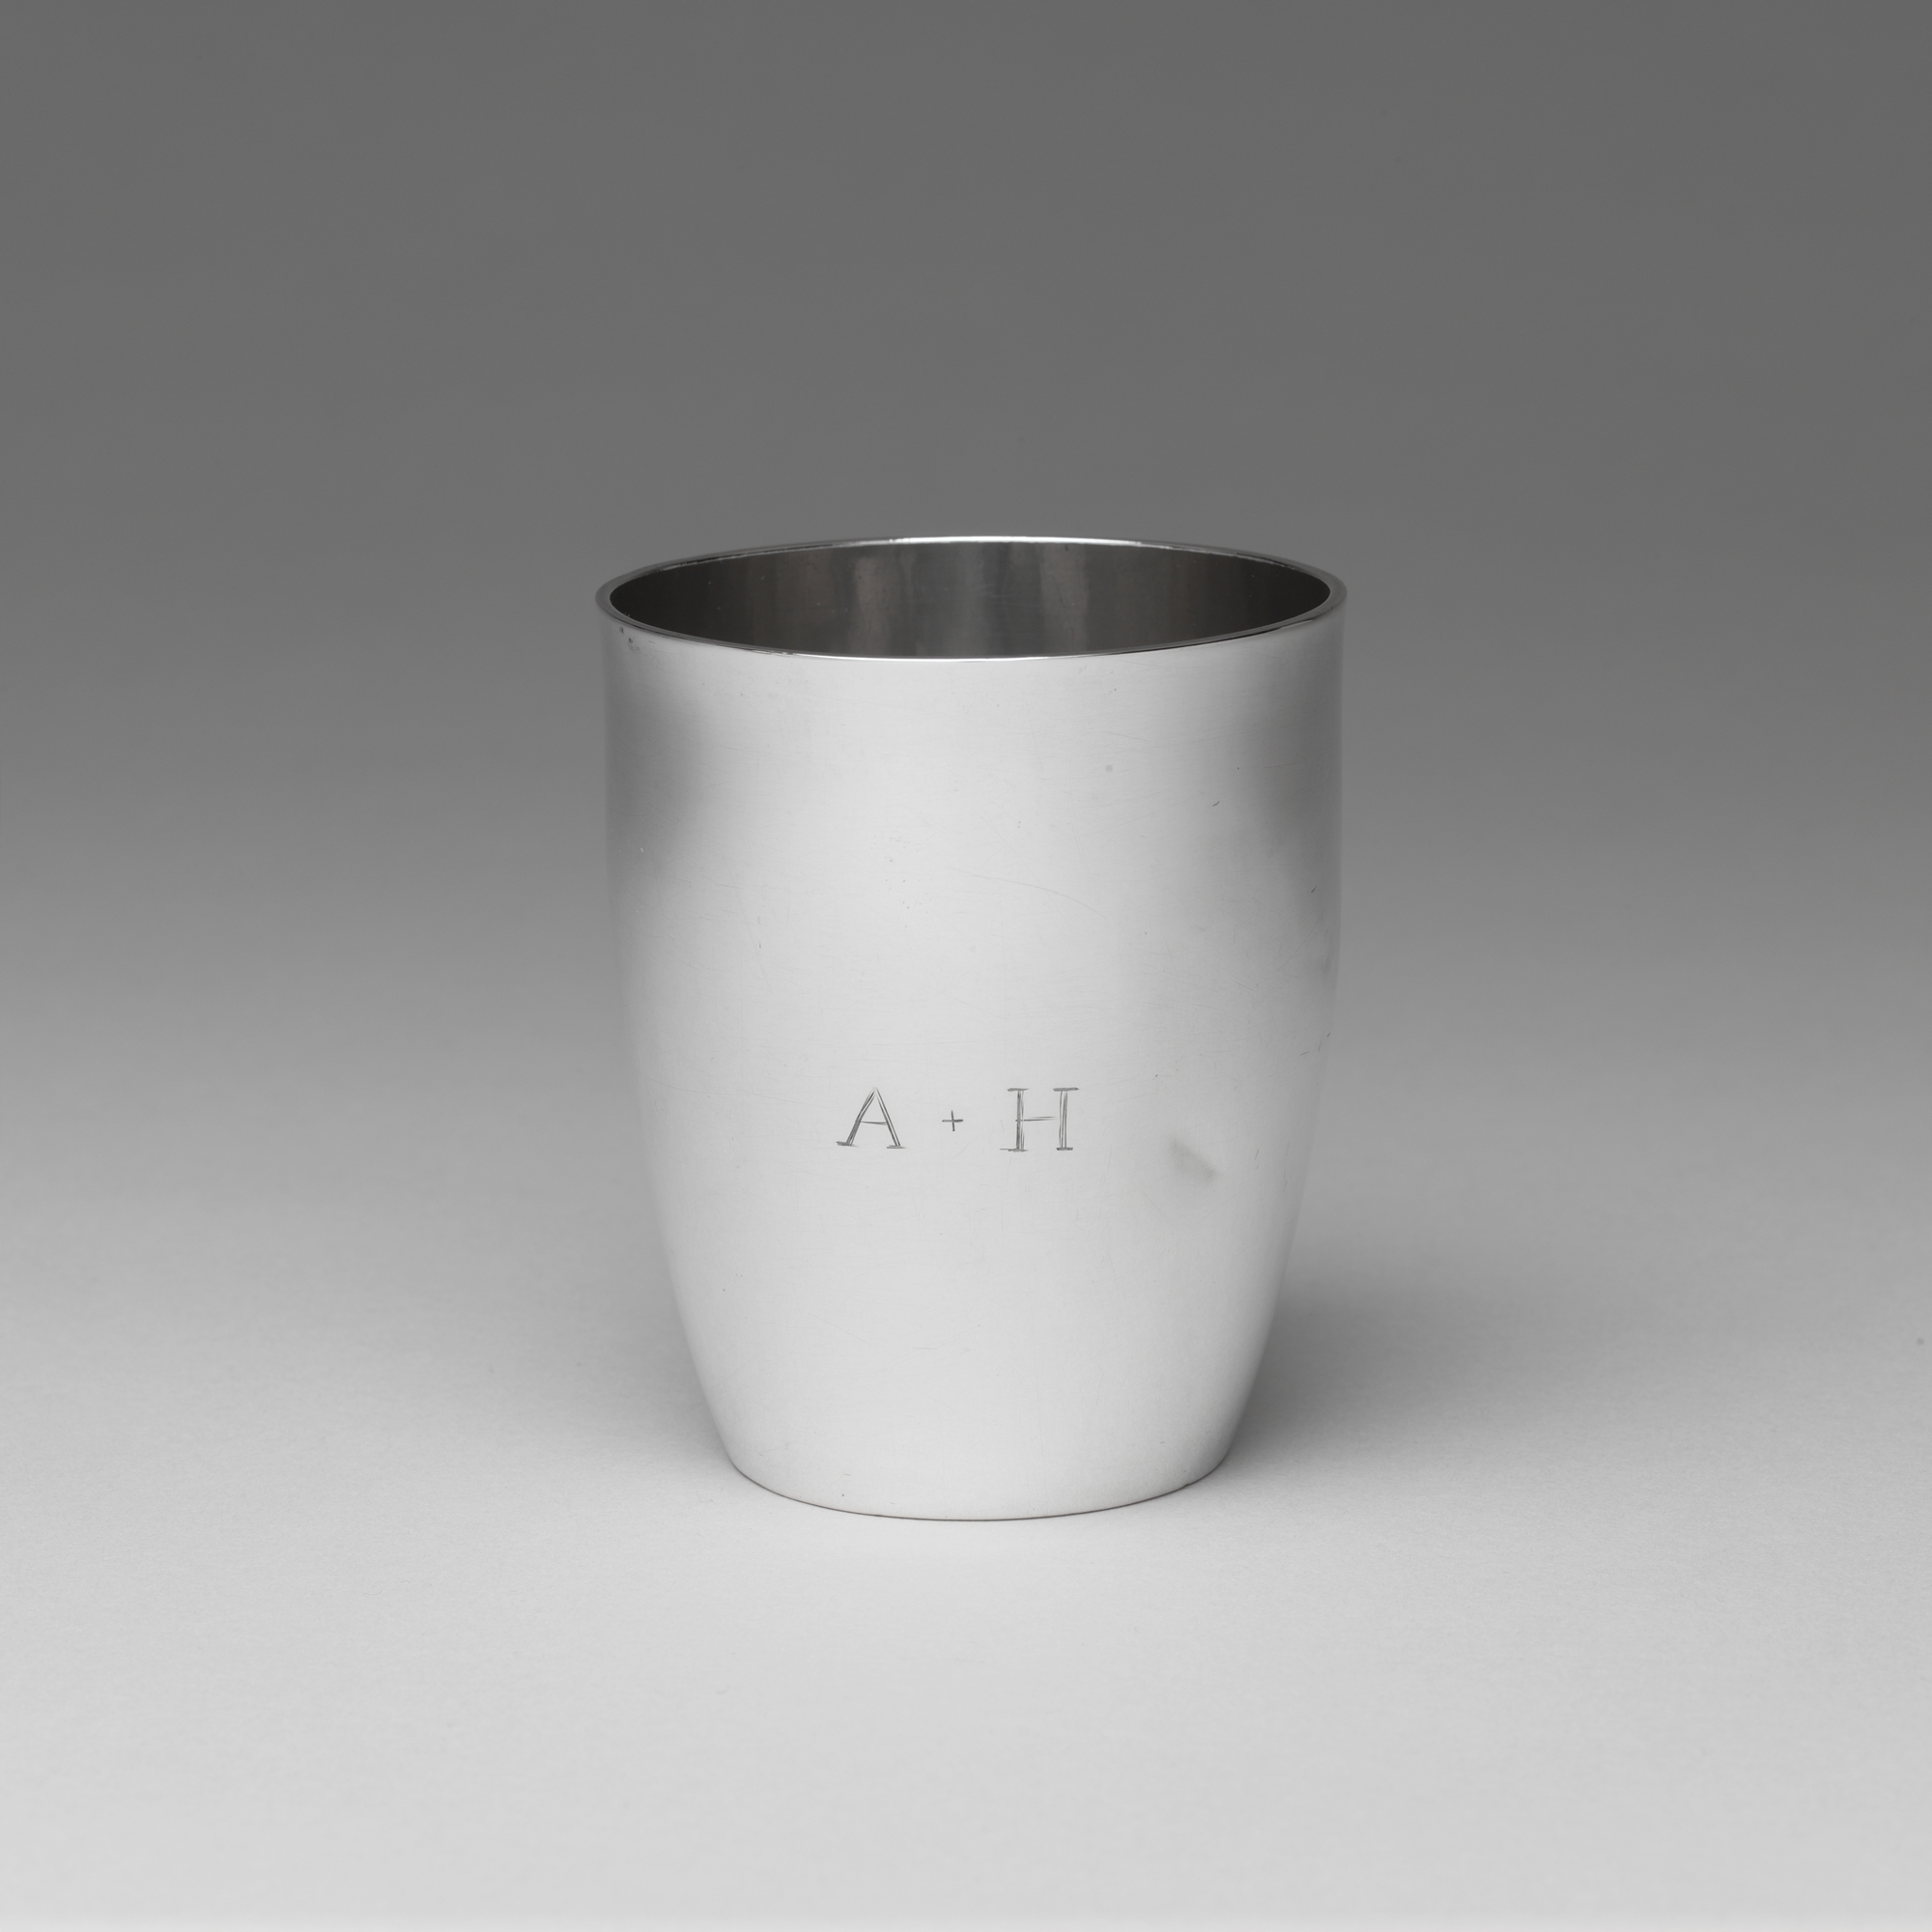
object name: beaker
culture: american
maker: david moseley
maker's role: maker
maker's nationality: american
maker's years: 1752-1812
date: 1780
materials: silver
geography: united states